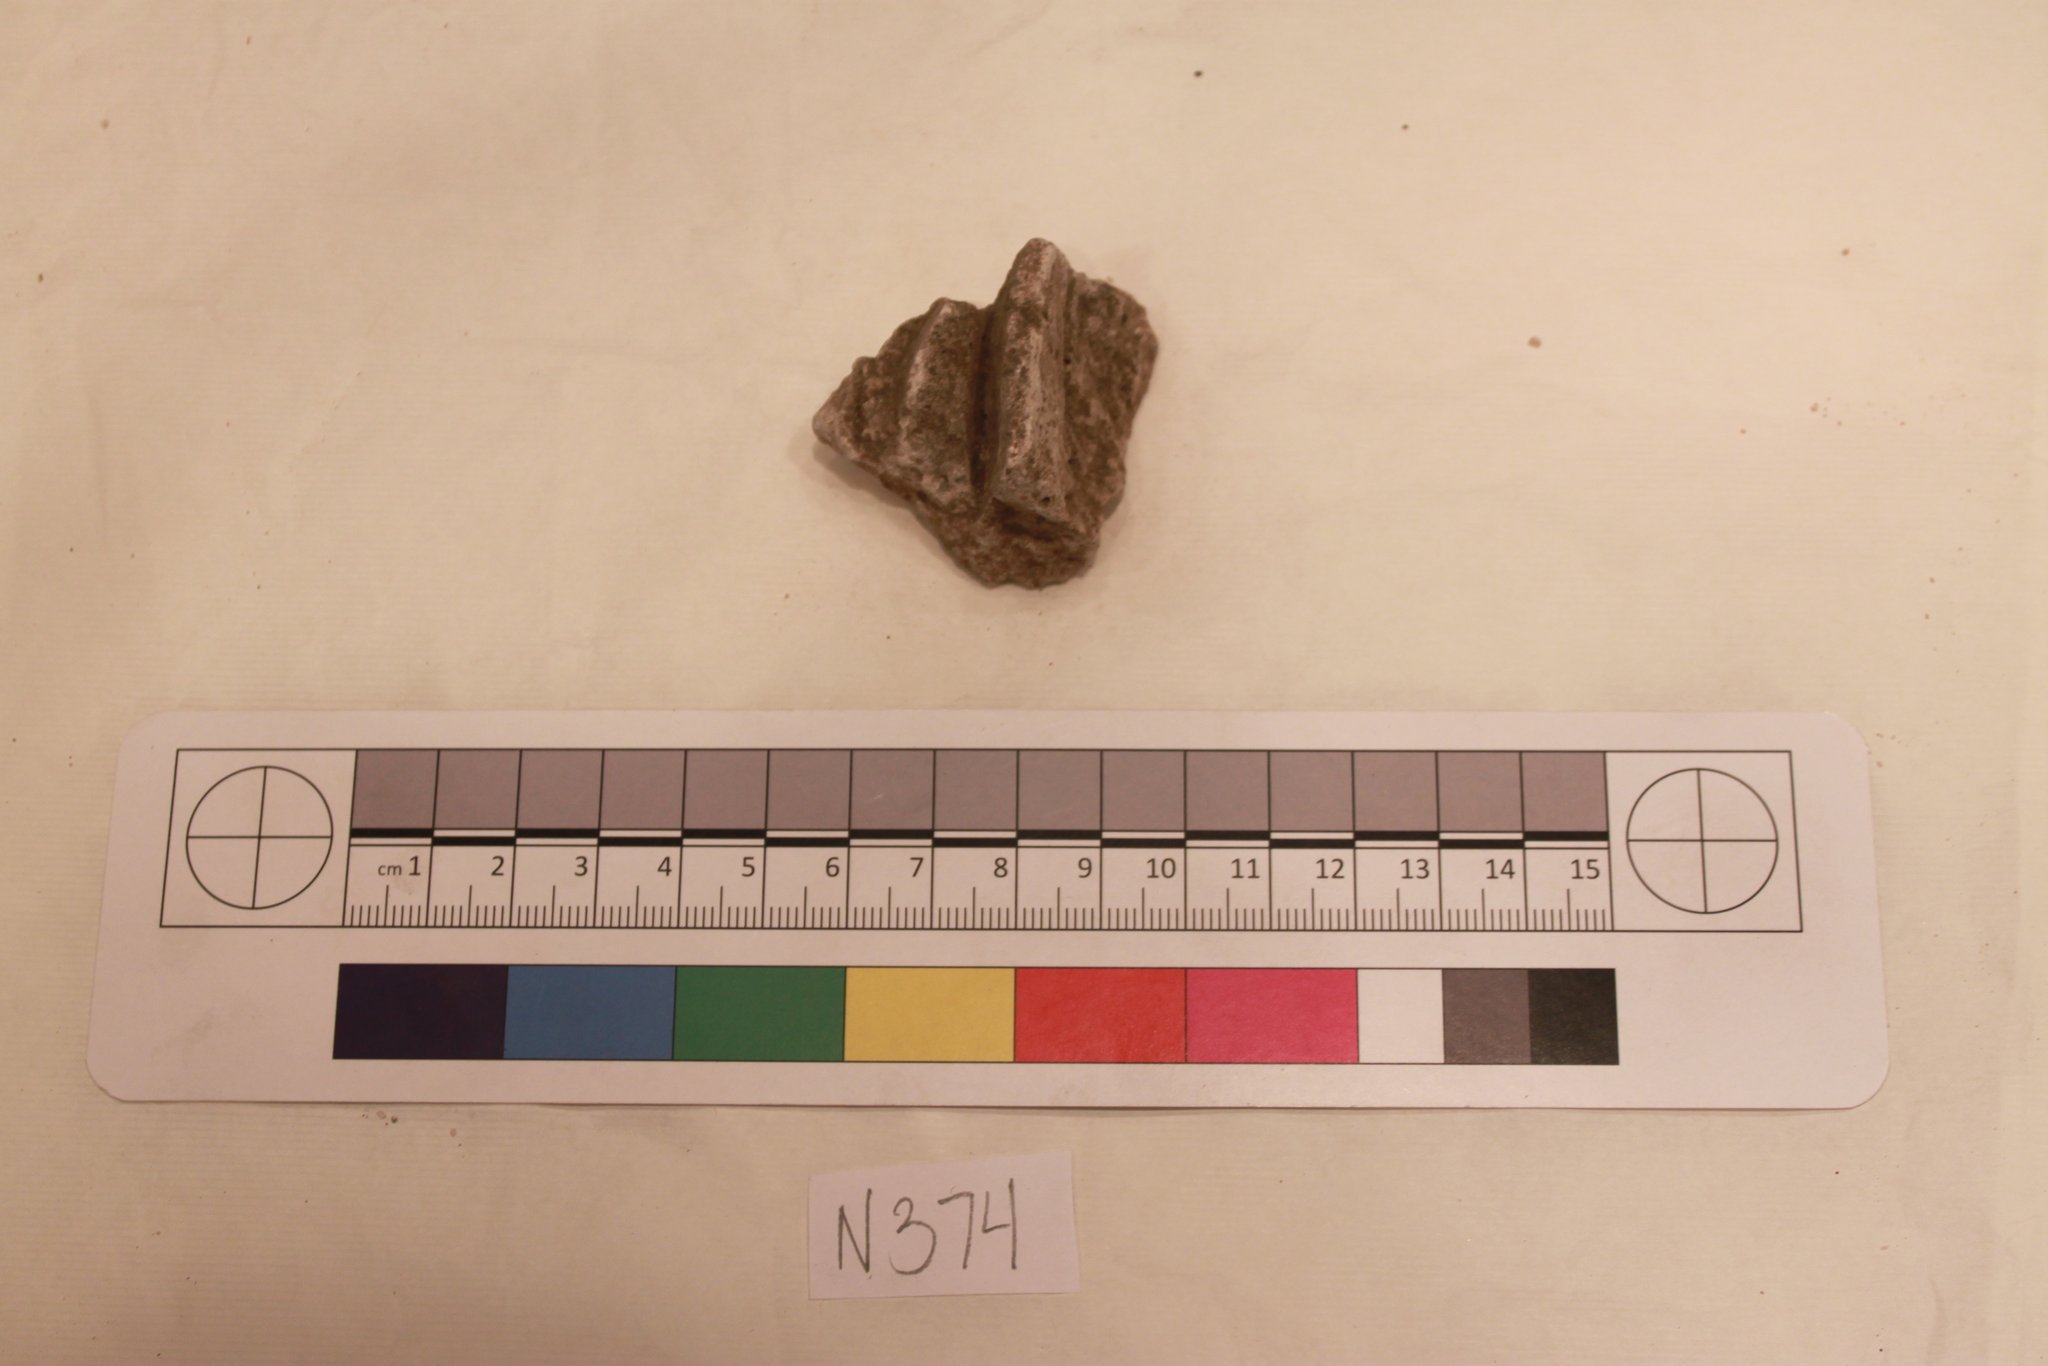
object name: fragment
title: Stucco Fragment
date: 701-1200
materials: plaster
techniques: carving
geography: iran